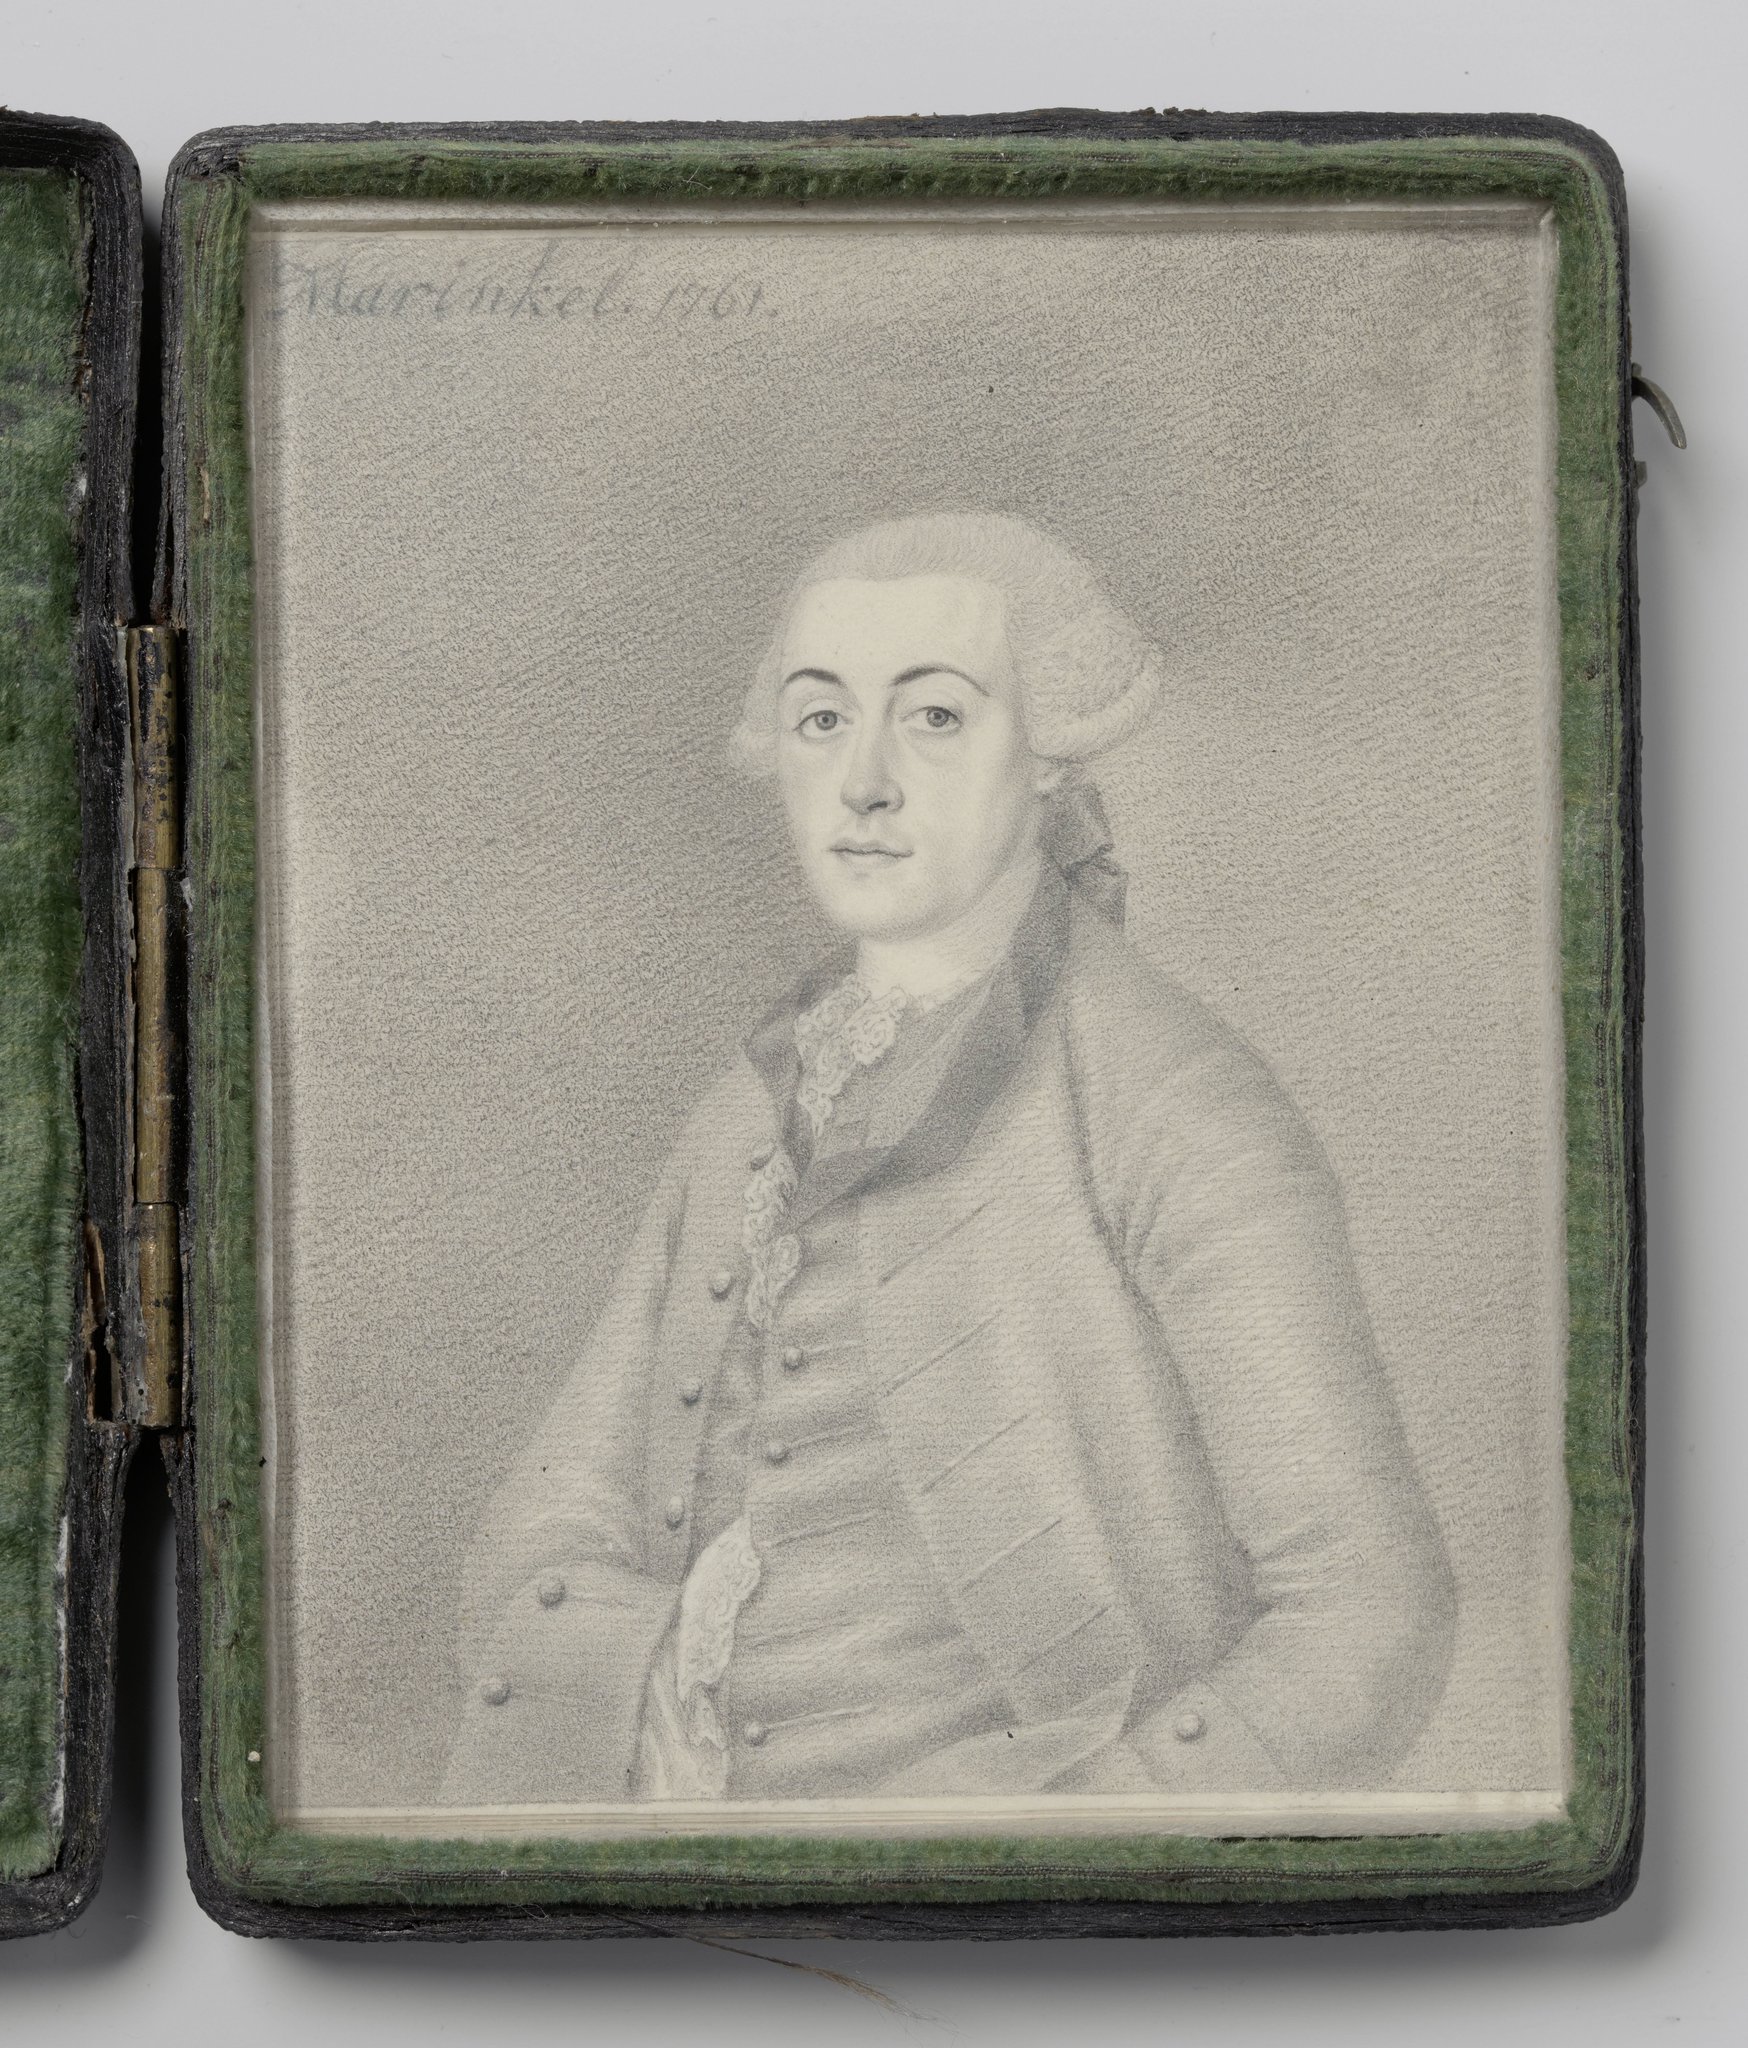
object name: painting, miniature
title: Portret van een man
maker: joseph marinkel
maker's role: miniatuurschilder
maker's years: 1732-1782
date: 1761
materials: glass, leather, metal, parchment, pencil, textile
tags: historical persons not known by name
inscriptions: signature and date: ‘Marinkel. 1761’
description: Joseph Marinkelle (1732 - 1782). Portrait of a man. Pencil on vellum, in case..., 1761. Given by Mrs J.H.M. Staring-de Mol van Otterloo, Vorden, 1981.